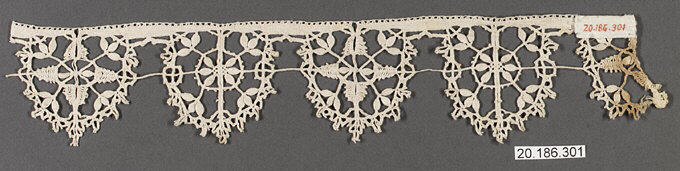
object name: edging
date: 1601-1700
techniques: lace